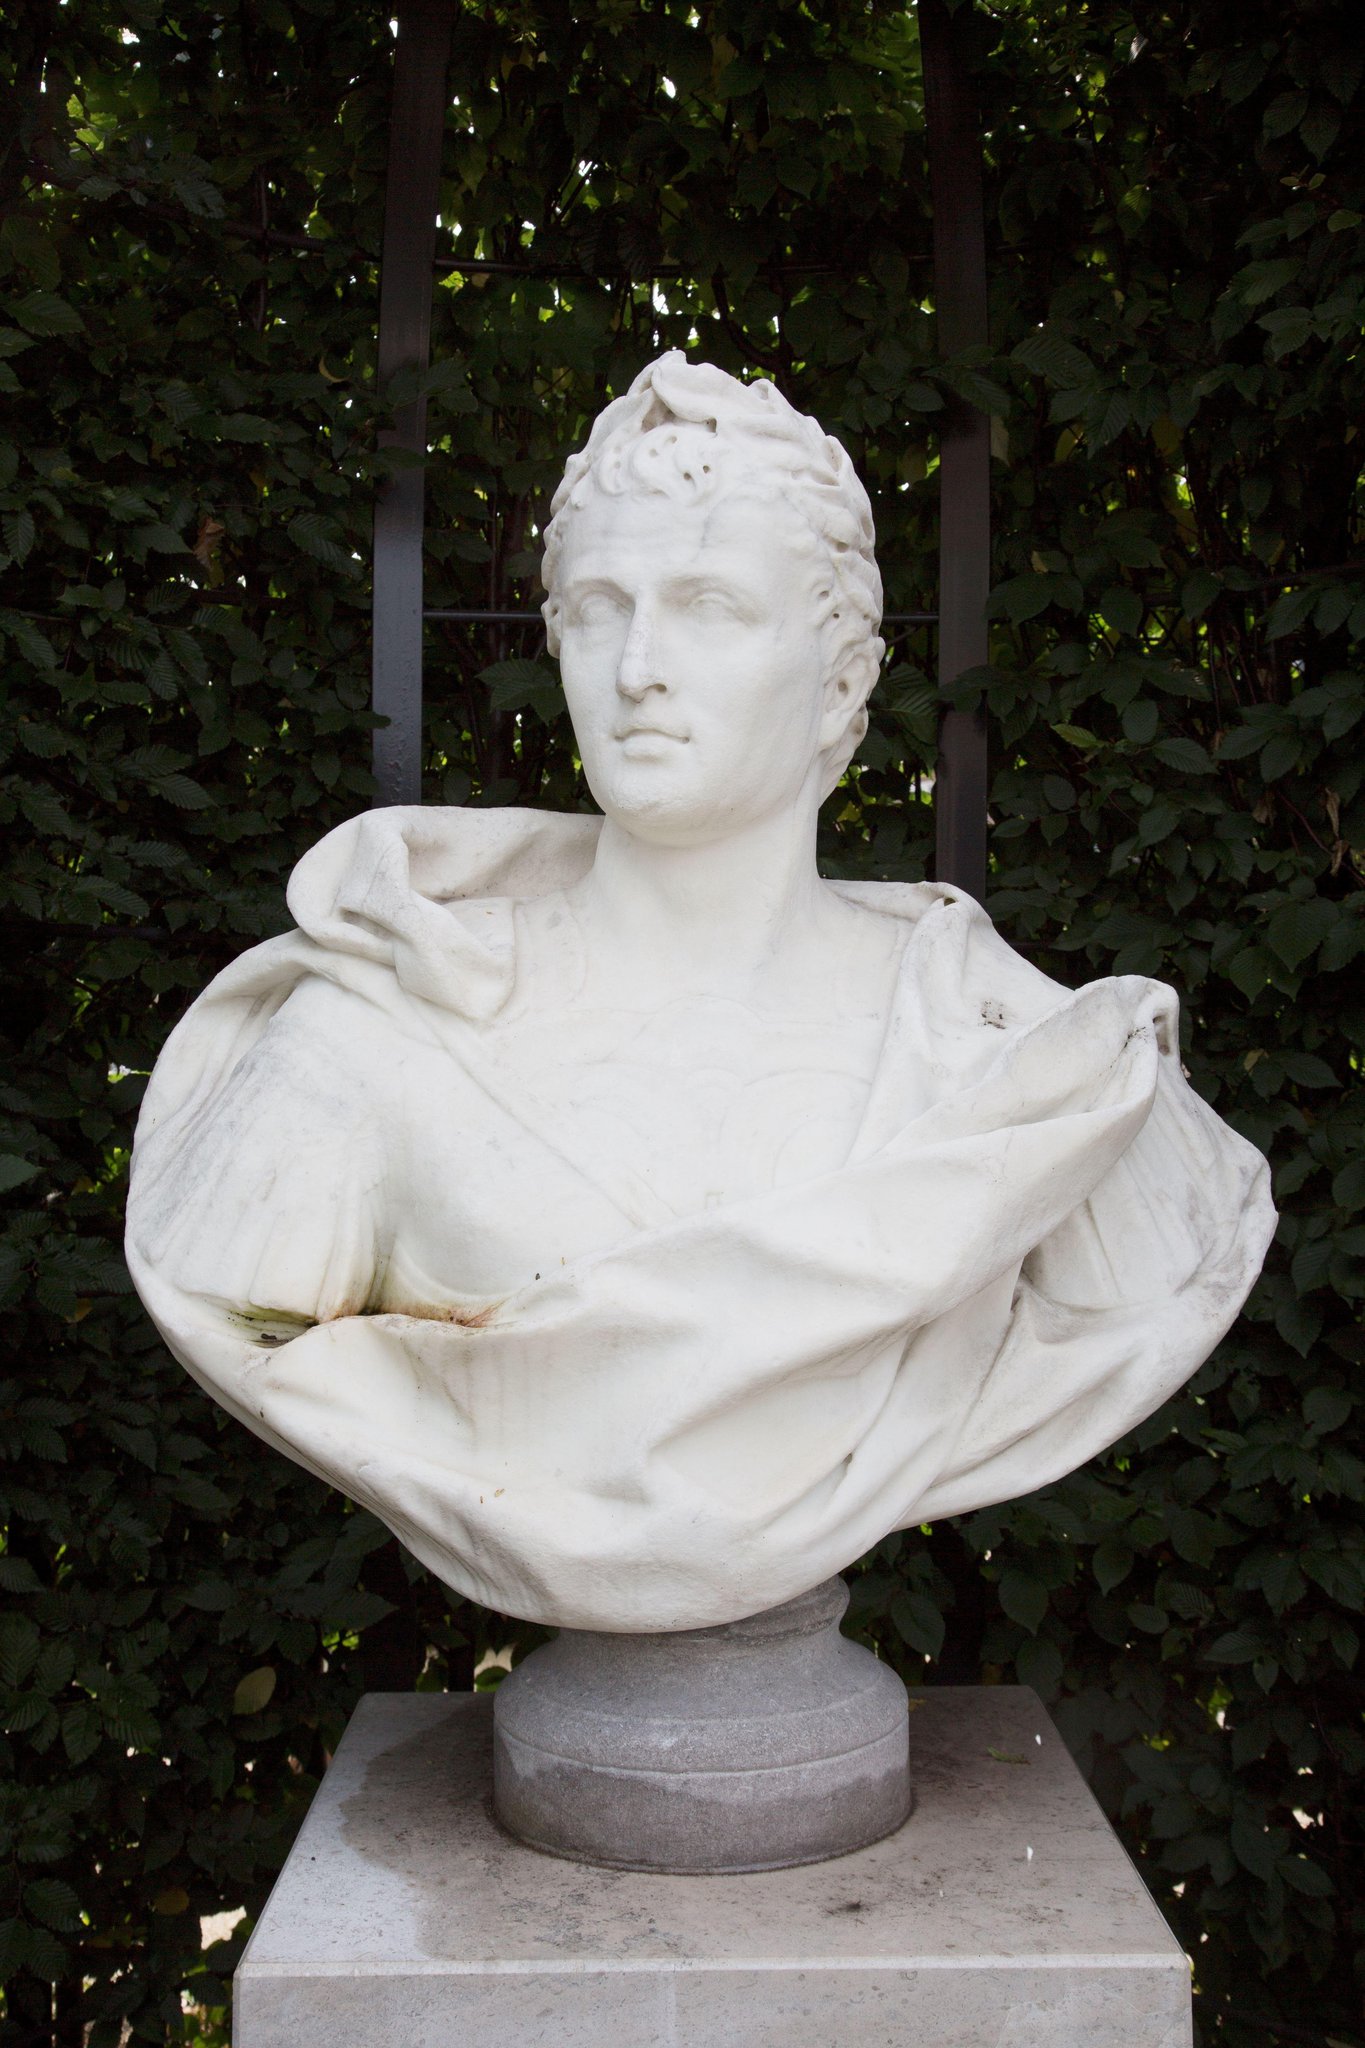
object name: tuinbeeld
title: Bust of Emperor Julius Caesar (100-44 BC) or Galba (3-69)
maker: Anonymous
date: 1700-1750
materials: marble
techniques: carved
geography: amsterdam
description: Statuary was often used in the 17th century to decorate the geometrically designed Baroque gardens. Popular features included busts of Roman emperors. These two marble sculptures date from the 18th century; it is no longer known which Roman emperors they represent.